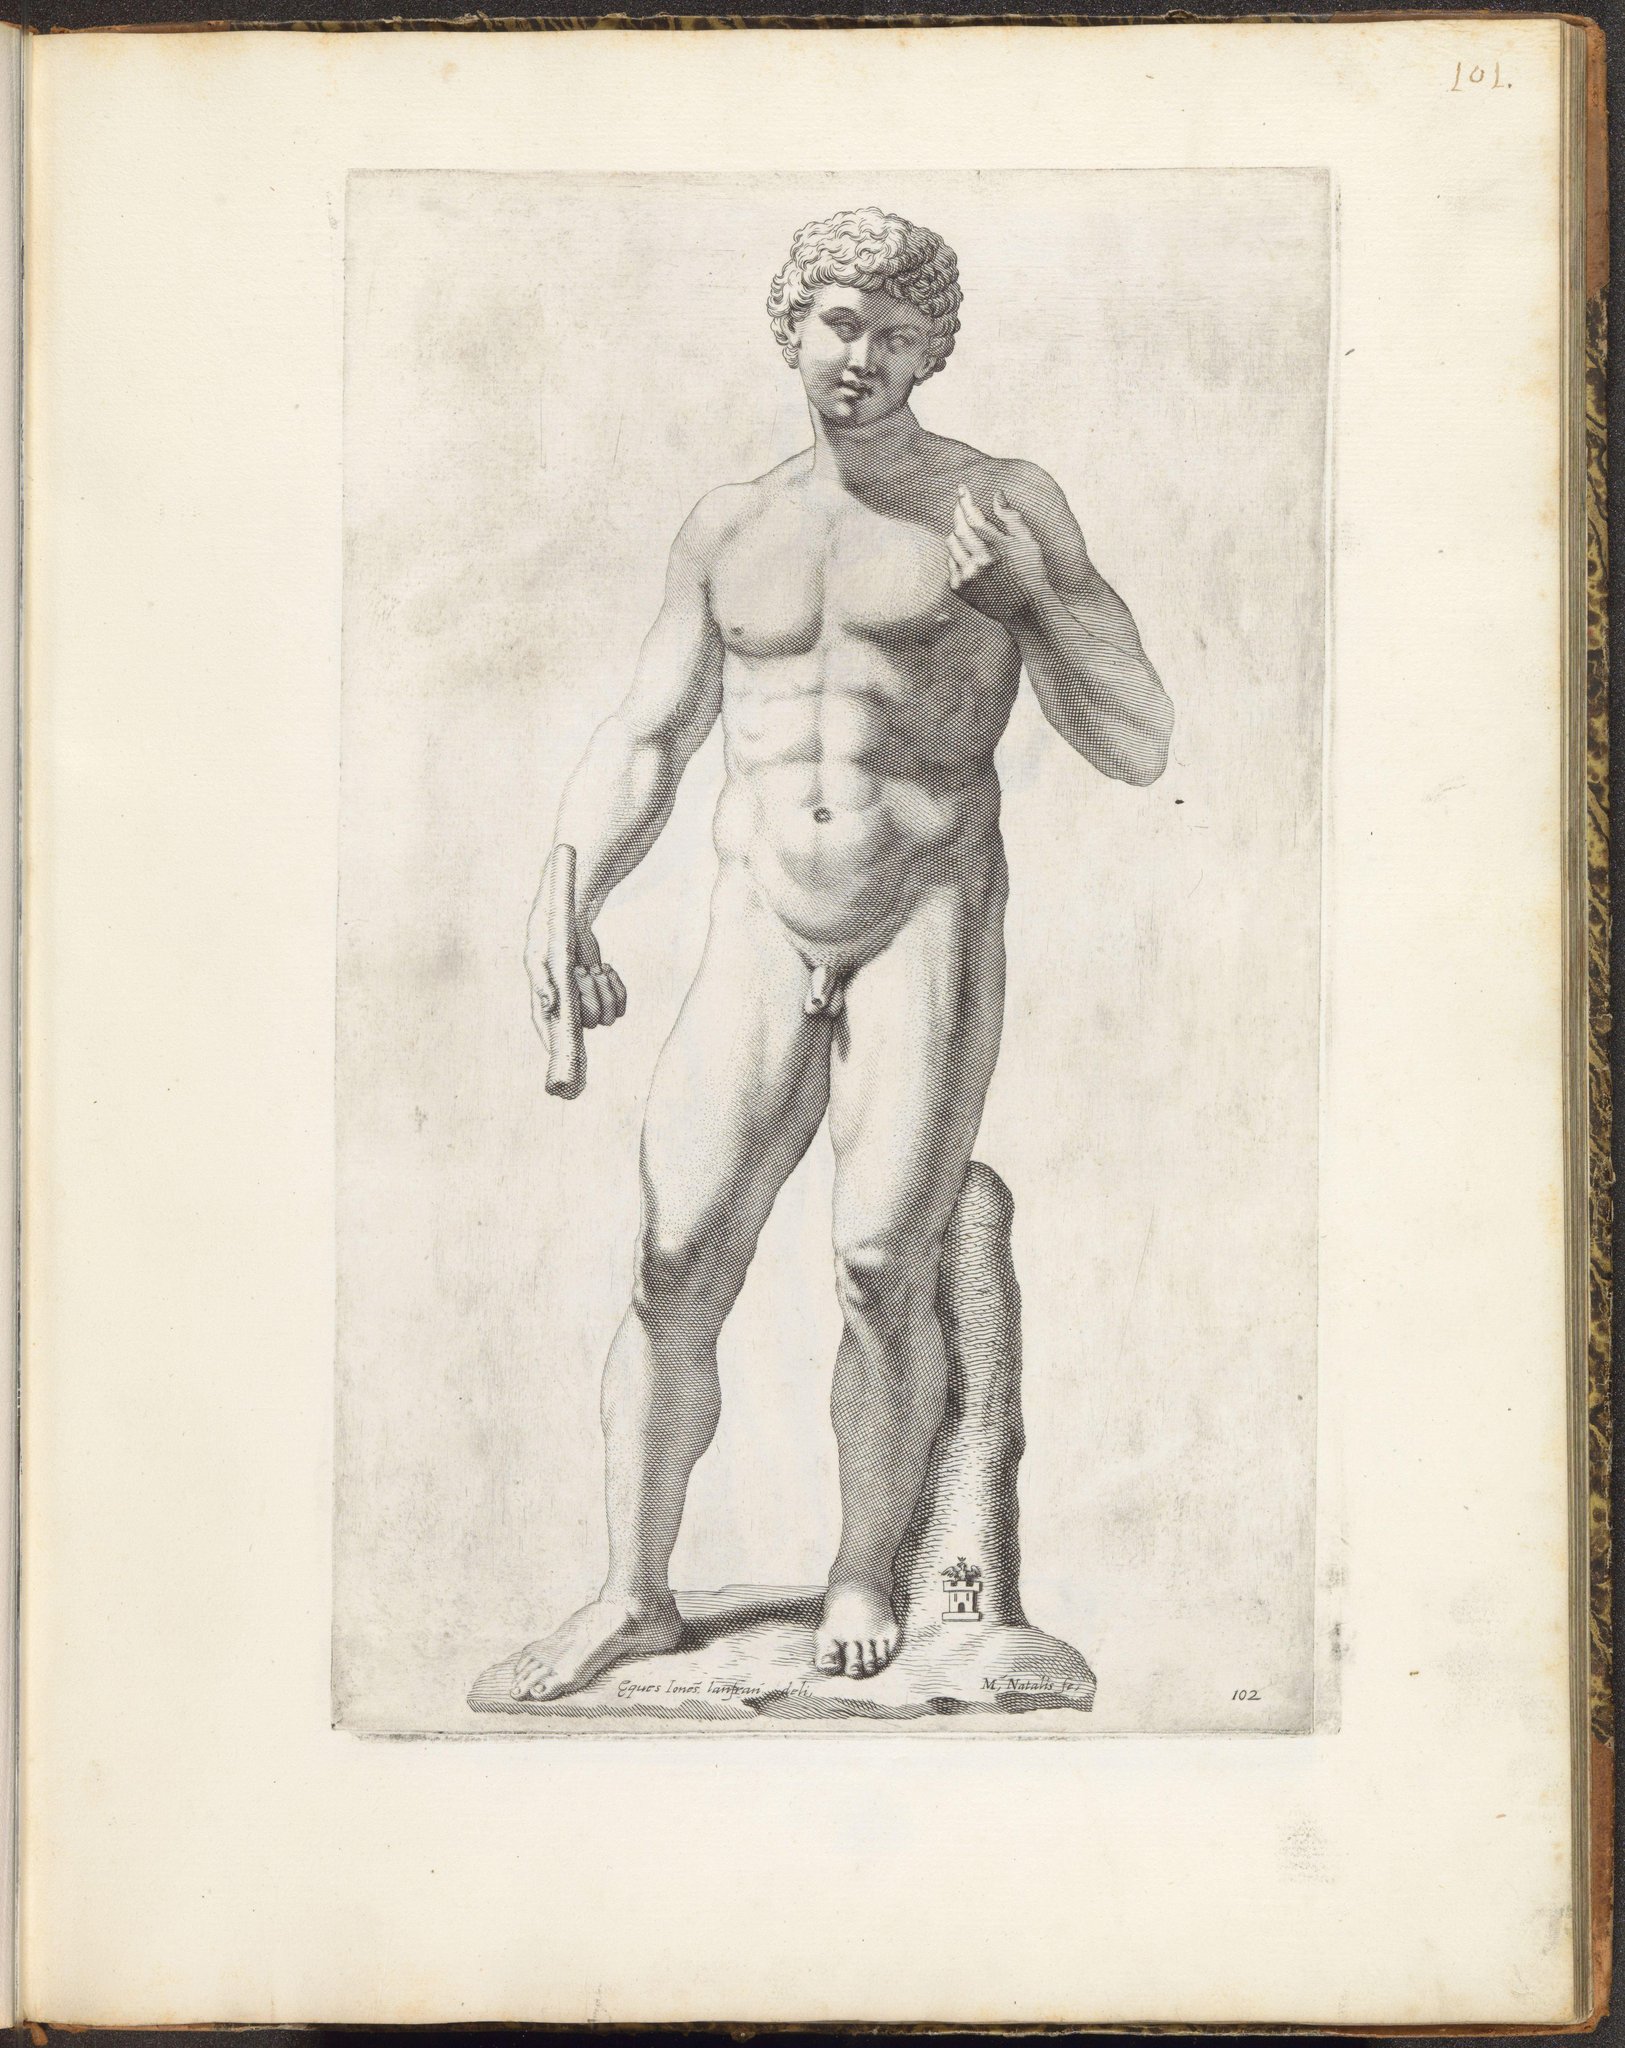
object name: album leaf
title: Standbeeld van een naakte Paris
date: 1636-1647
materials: paper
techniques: engraving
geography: rome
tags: piece of sculpture, reproduction of a piece of sculpture, (story of) paris (alexander)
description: Standbeeld van een naakte Paris, in zijn rechterarm een stok, zijn linkerarm iets omhog geheven. Onder op de boomstam het wapen van Vincenzo Giustiniani. Prent maakt deel uit van een album met een serie prenten naar de sculpturen in de verzameling in de Galleria Giustiniani te Rome.